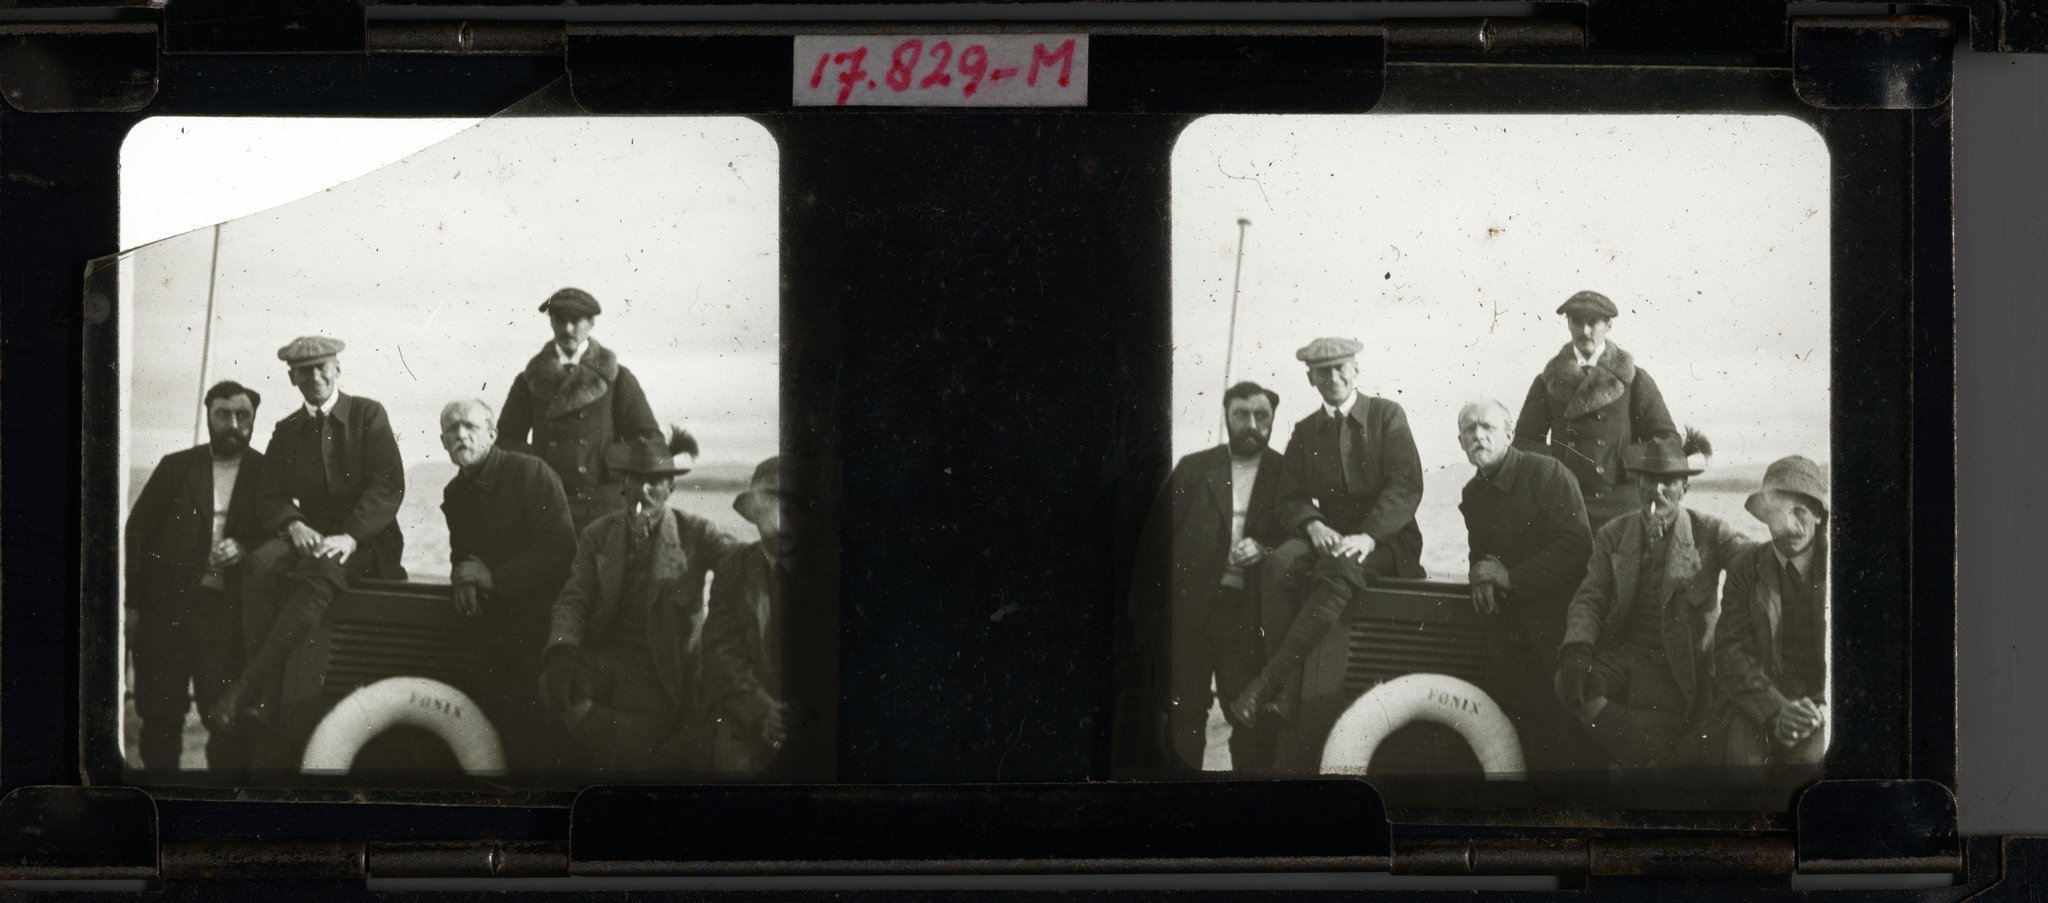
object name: album leaf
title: Mannen op het dek van het schip Fonix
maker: Anonymous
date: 1893-1923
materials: glass, metal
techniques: slide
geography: paris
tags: crew ~ ship